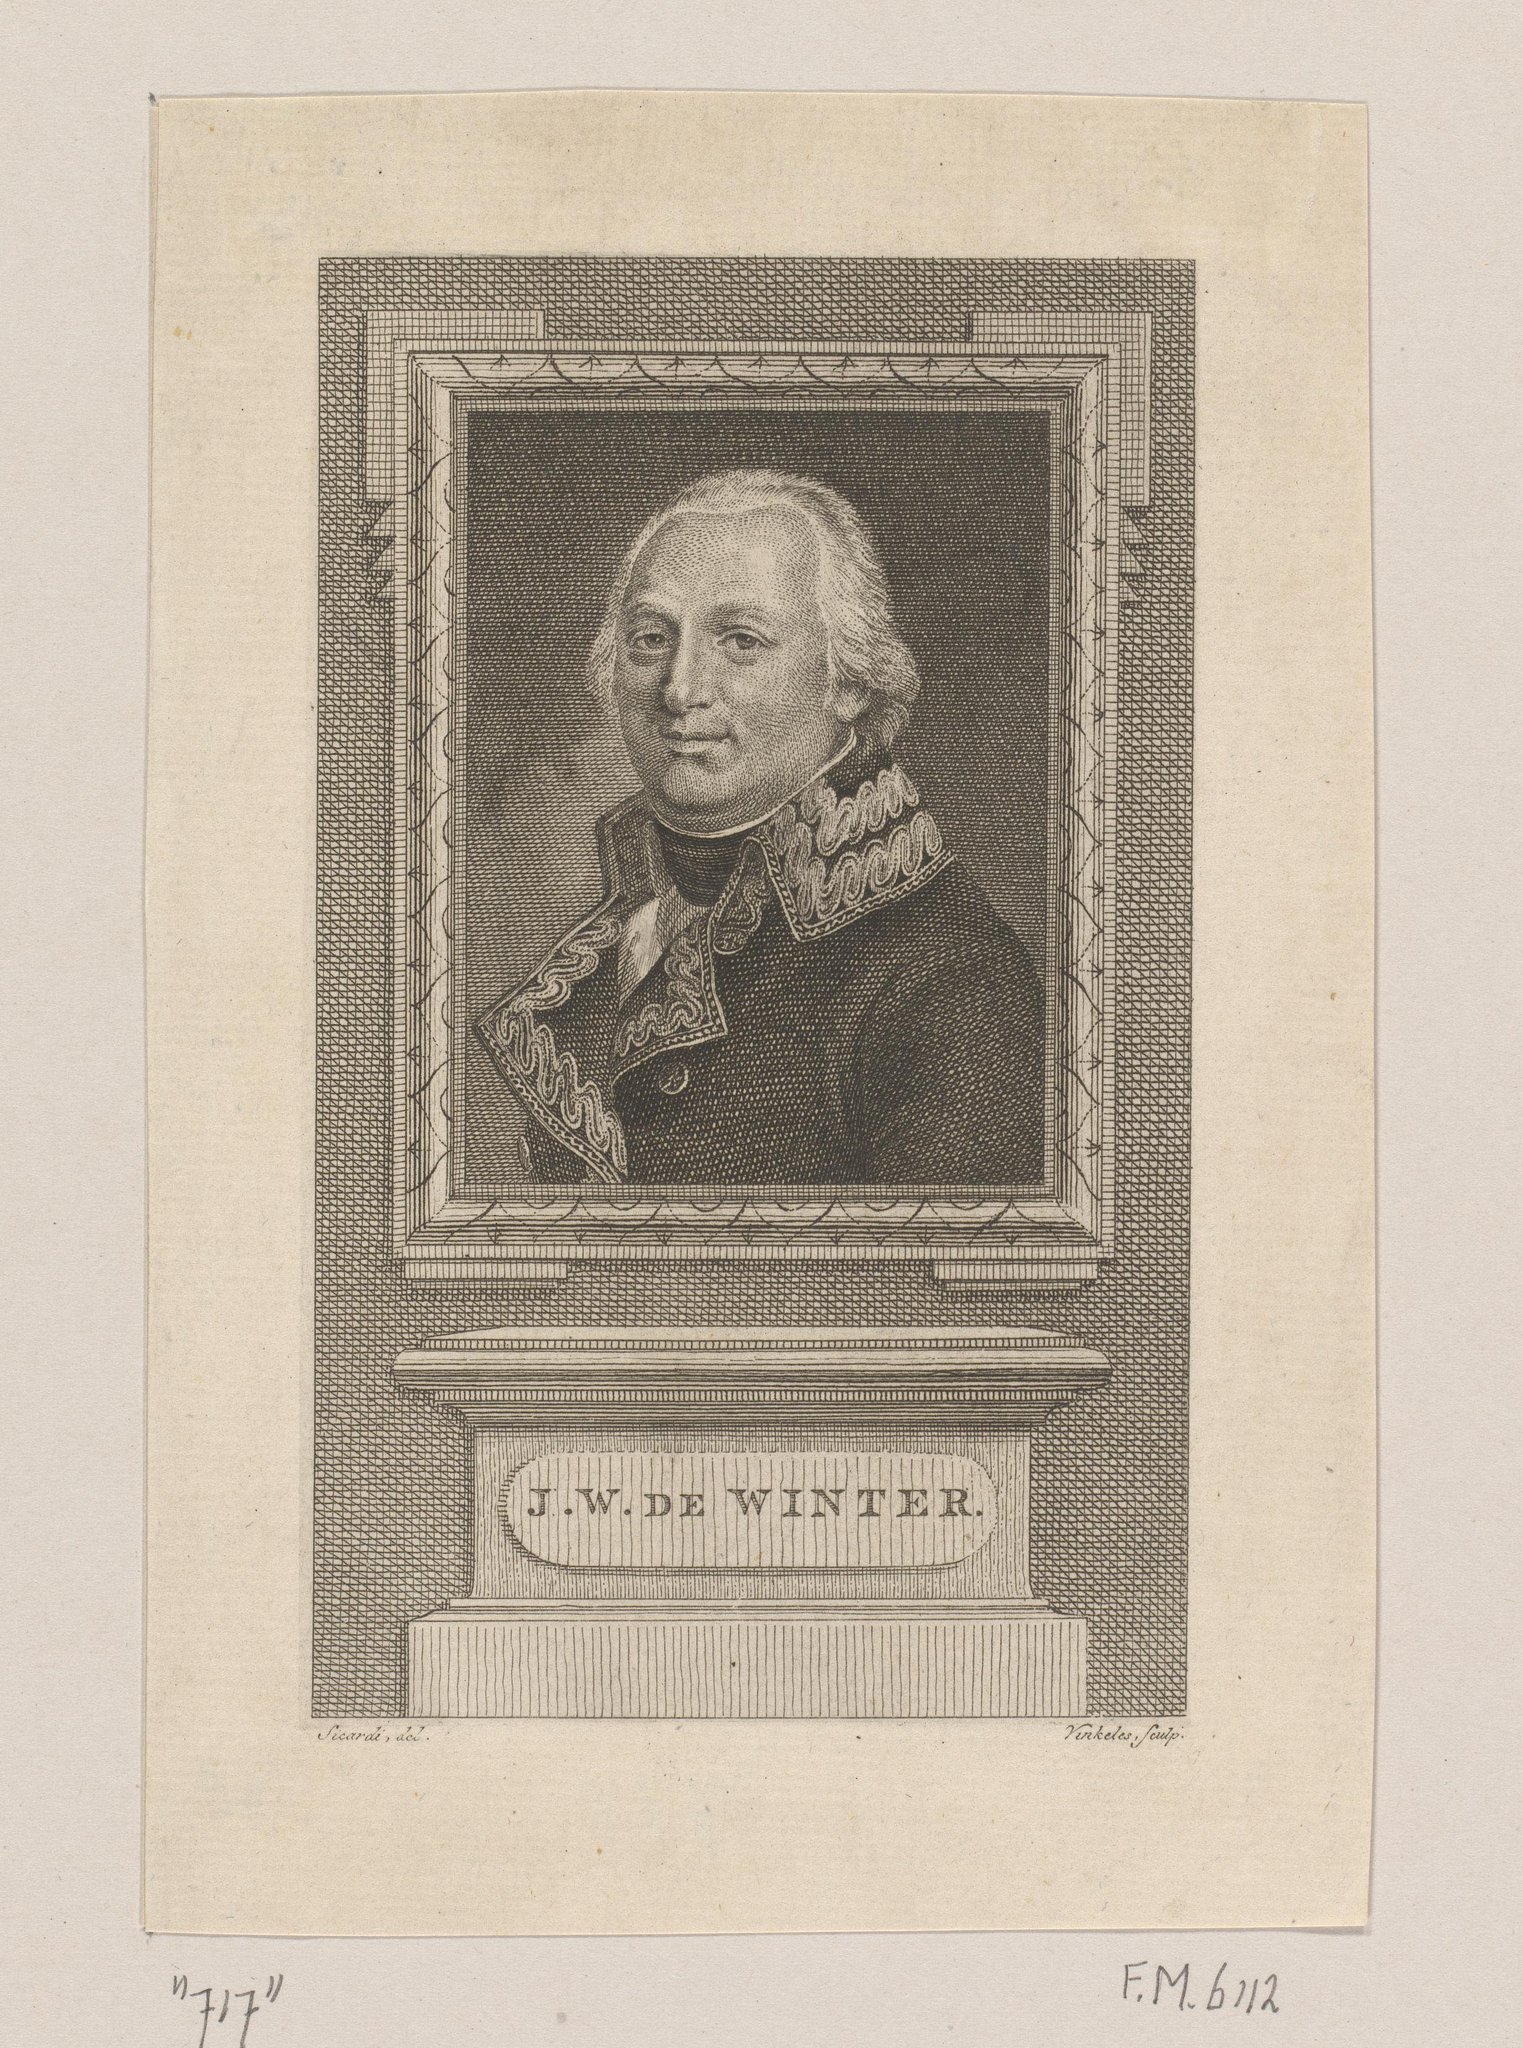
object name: book illustration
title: Portret van Jan Willem de Winter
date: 1804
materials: paper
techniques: engraving, etching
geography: amsterdam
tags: paris, jan willem de winter, commander-in-chief, general, marshal, historical persons, commander-in-chief, admiral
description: Prent uit: Wagenaar, Jan. Vaderlandsche historie, (...) ten vervolge van Wagenaars Vaderlandsche historie. Amsterdam: Johannes Allart, 1804, dl. 32.